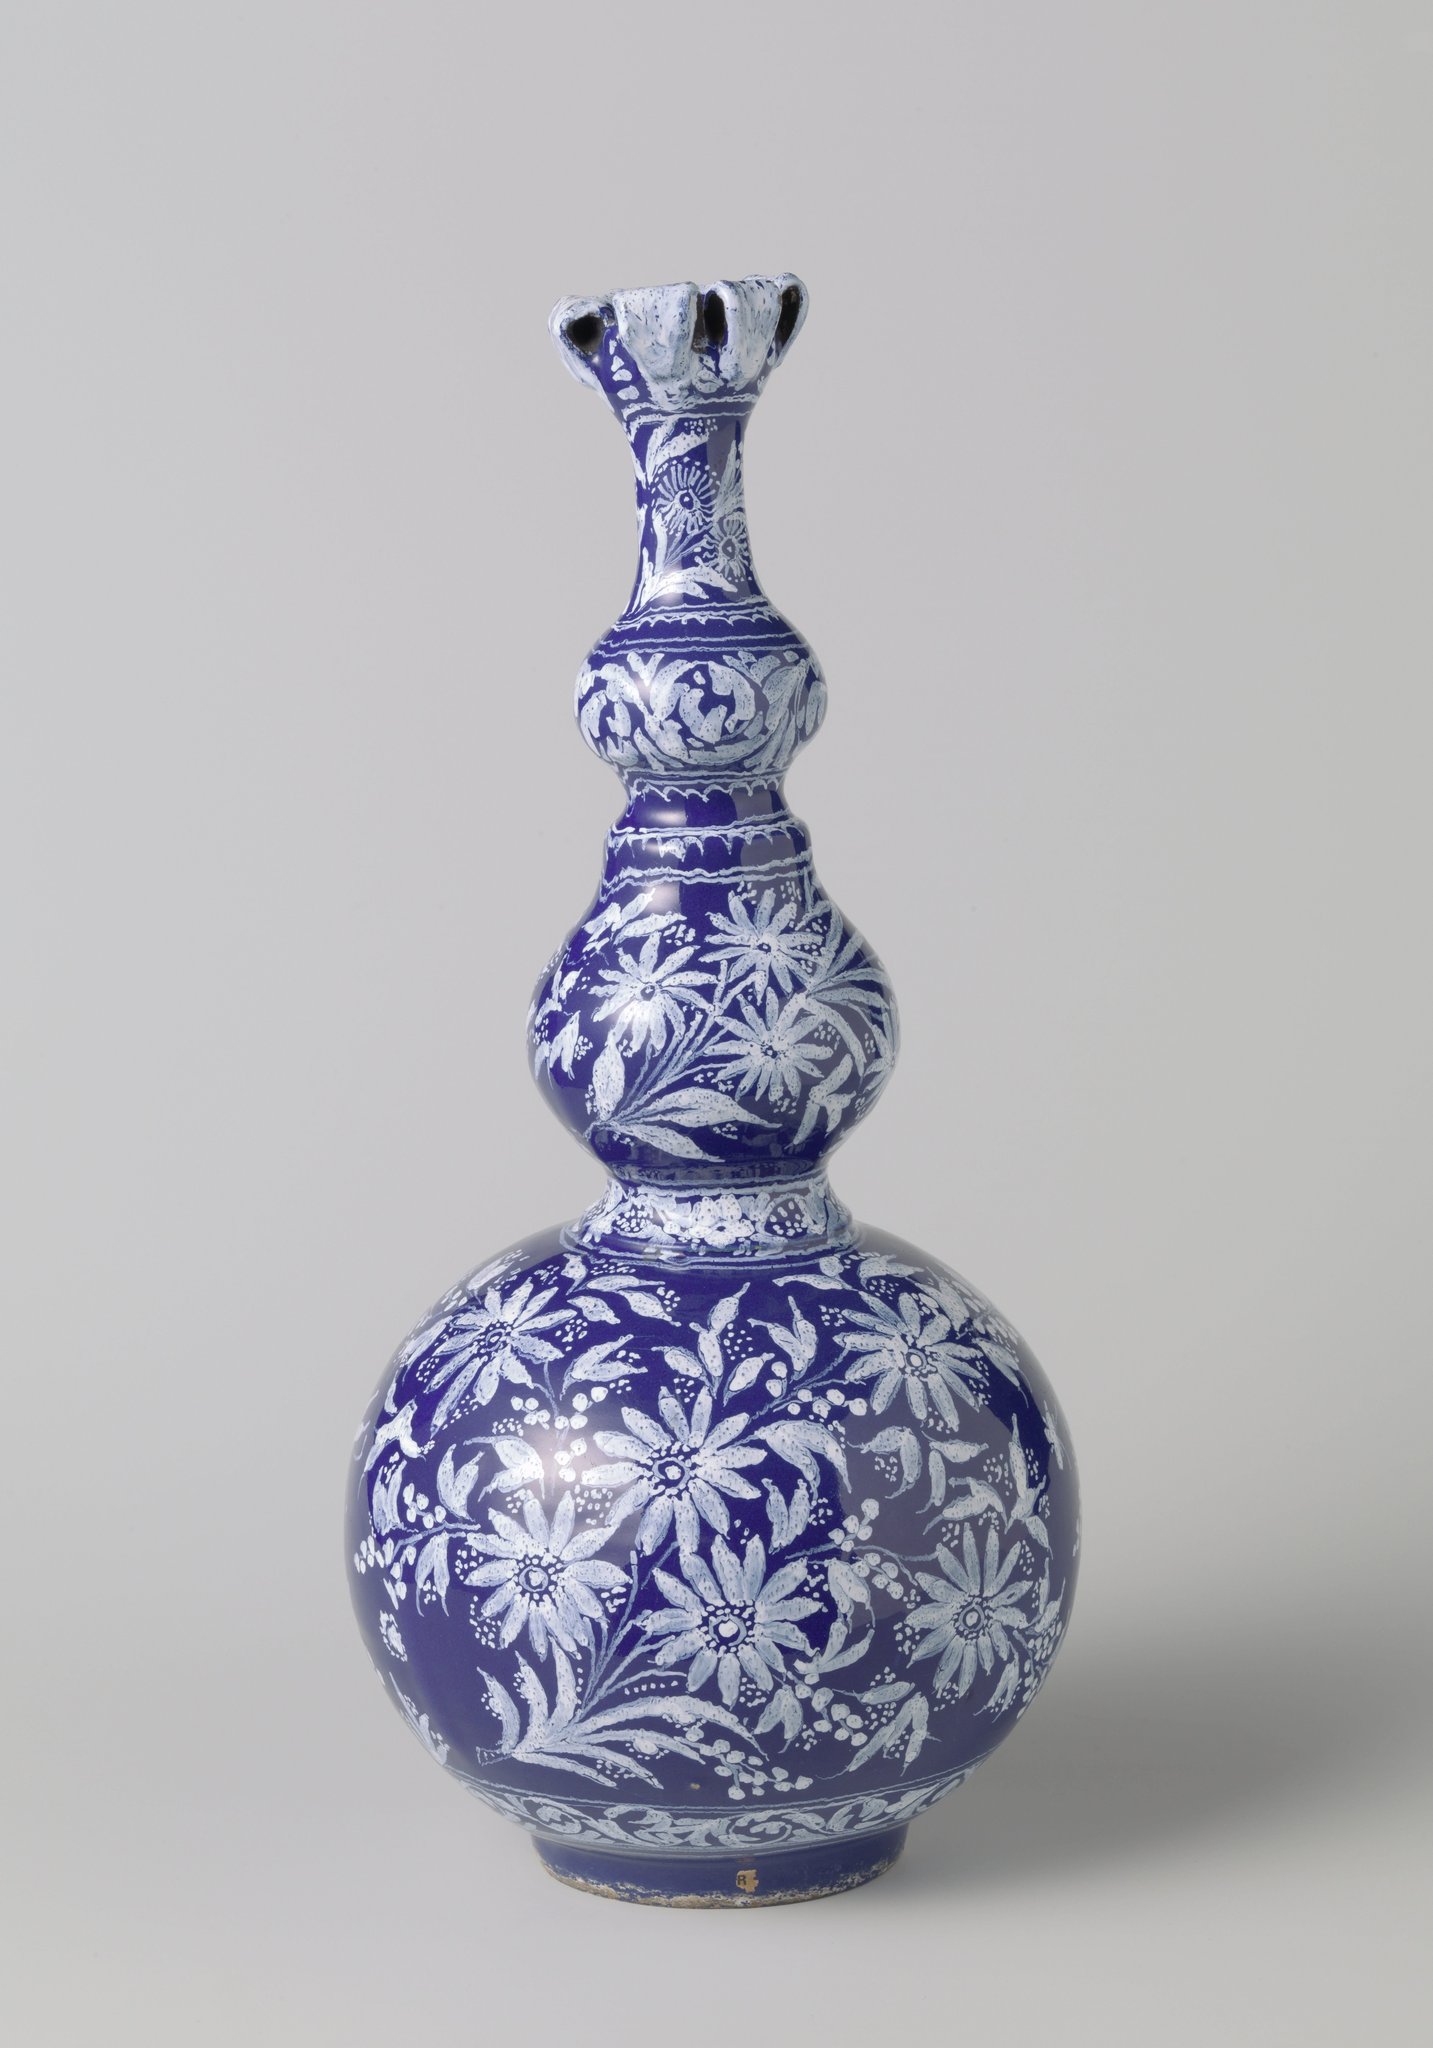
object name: bottle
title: Fles, veelkleurig beschilderd met bloemtakken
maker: Anonymous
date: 1690-1720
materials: faience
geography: nevers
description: Fles van faïence. Veelkleurig beschilderd met bloemtakken.